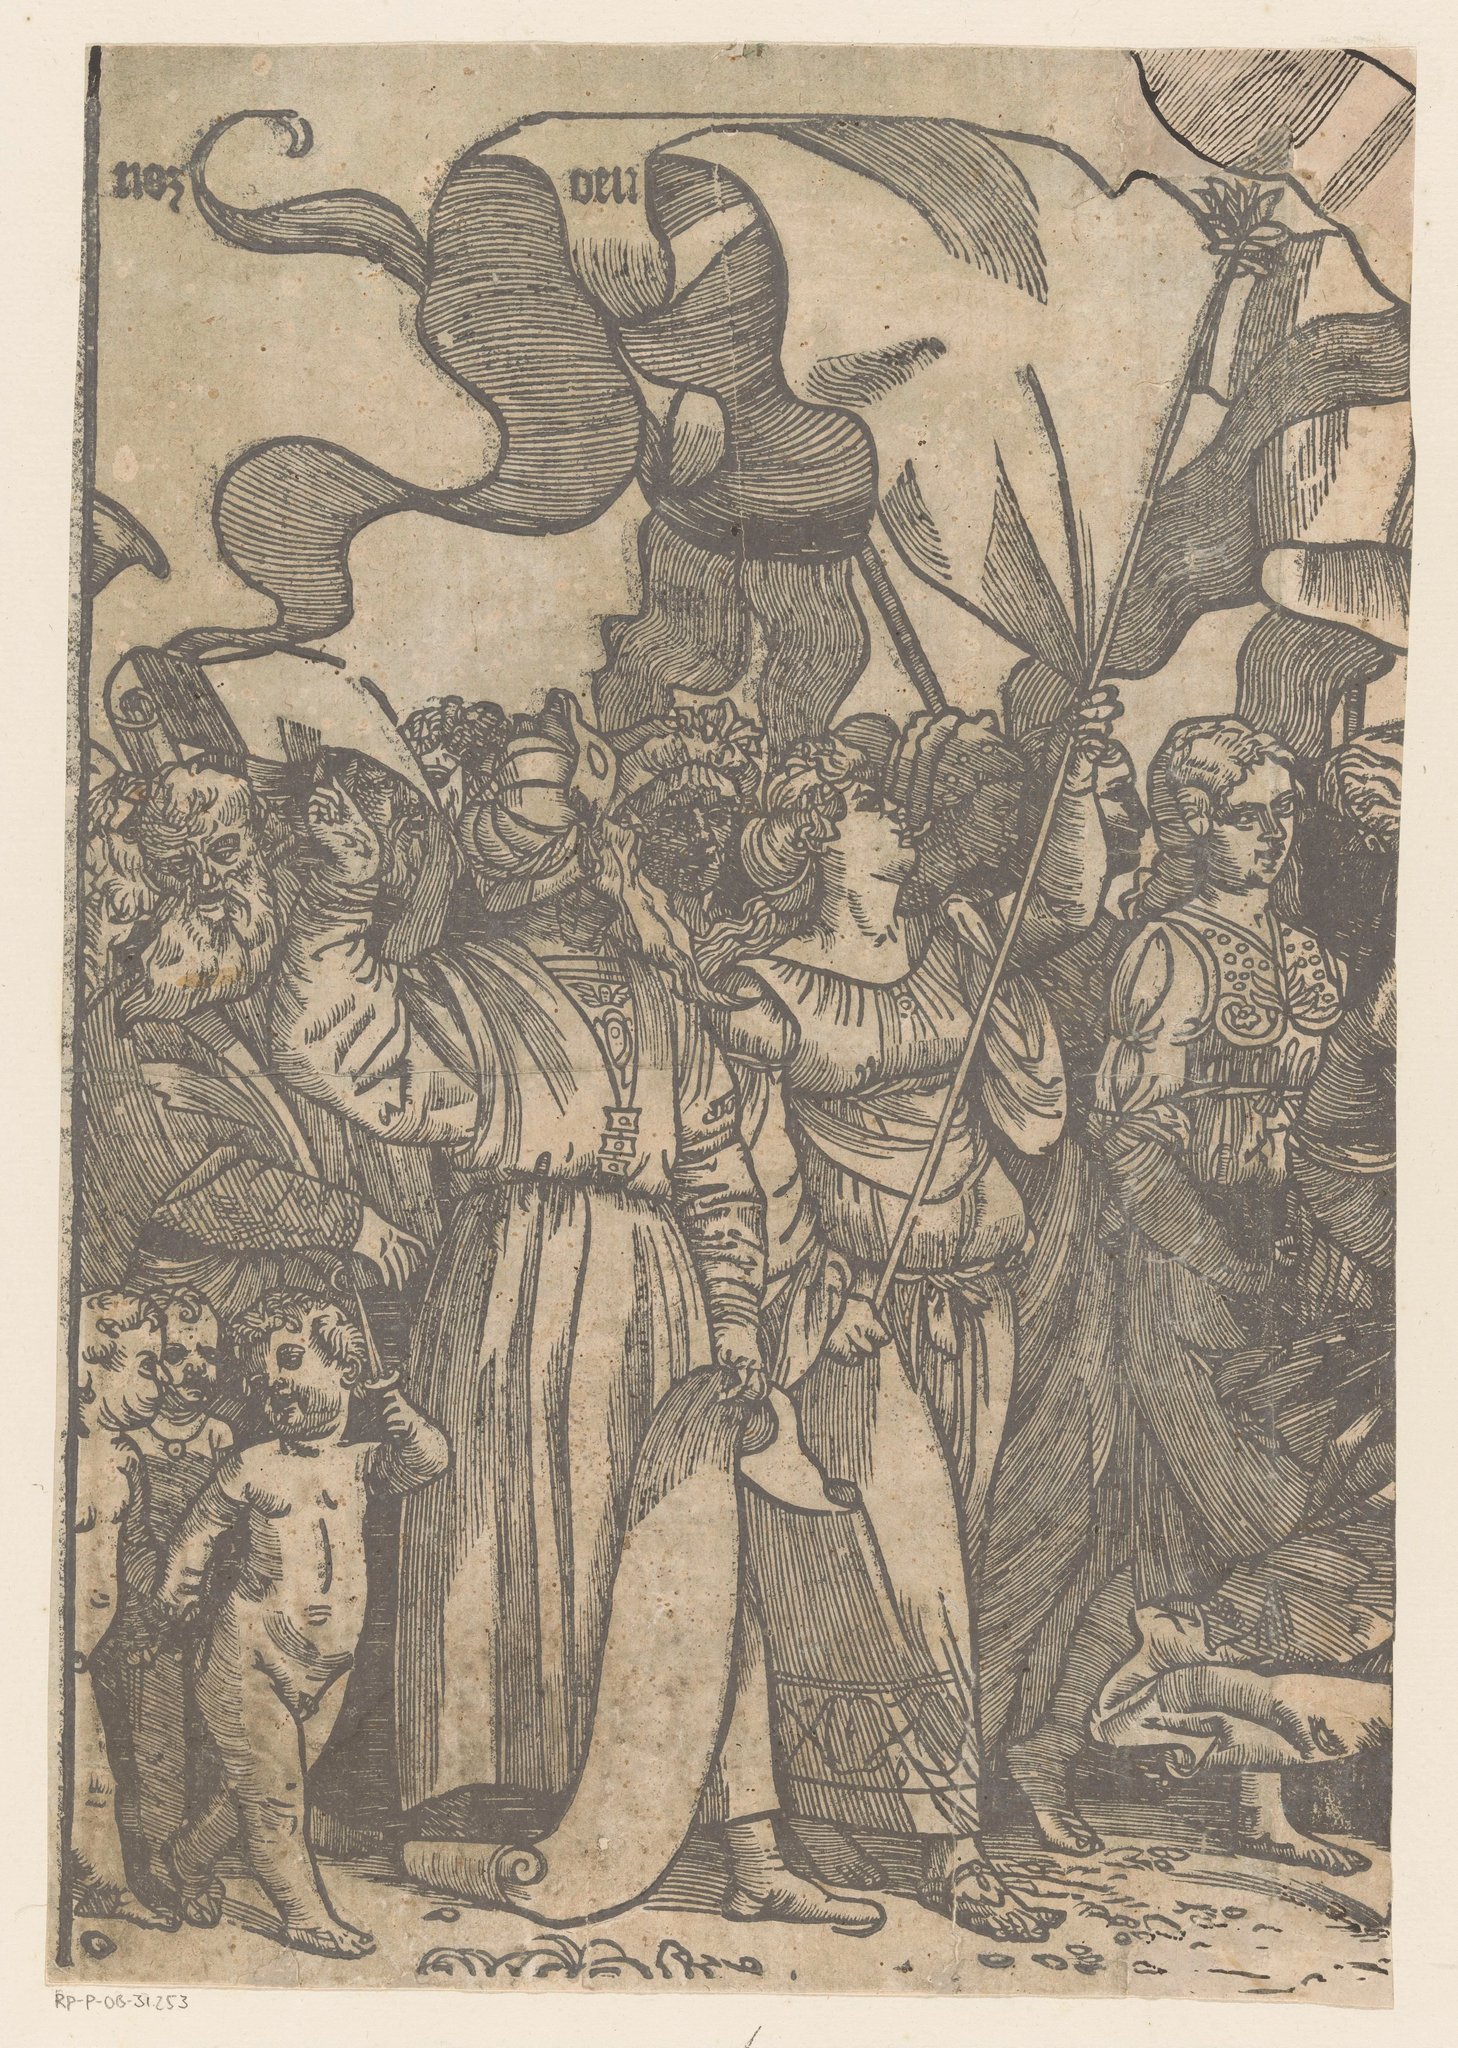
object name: print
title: Triomf van Christus (zevende deel)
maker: Anonymous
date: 1510-1511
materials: paper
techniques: woodcut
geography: italy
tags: sibyls, banner, standard (as symbol of the state, etc.)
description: Deze prent maakt onderdeel uit van een fries bestaande uit tien houtsneden die samen de Triomf van Christus vormen. Rechtsonder en rechtsboven is de prent beschadigd en aangevuld met pen in zwart.